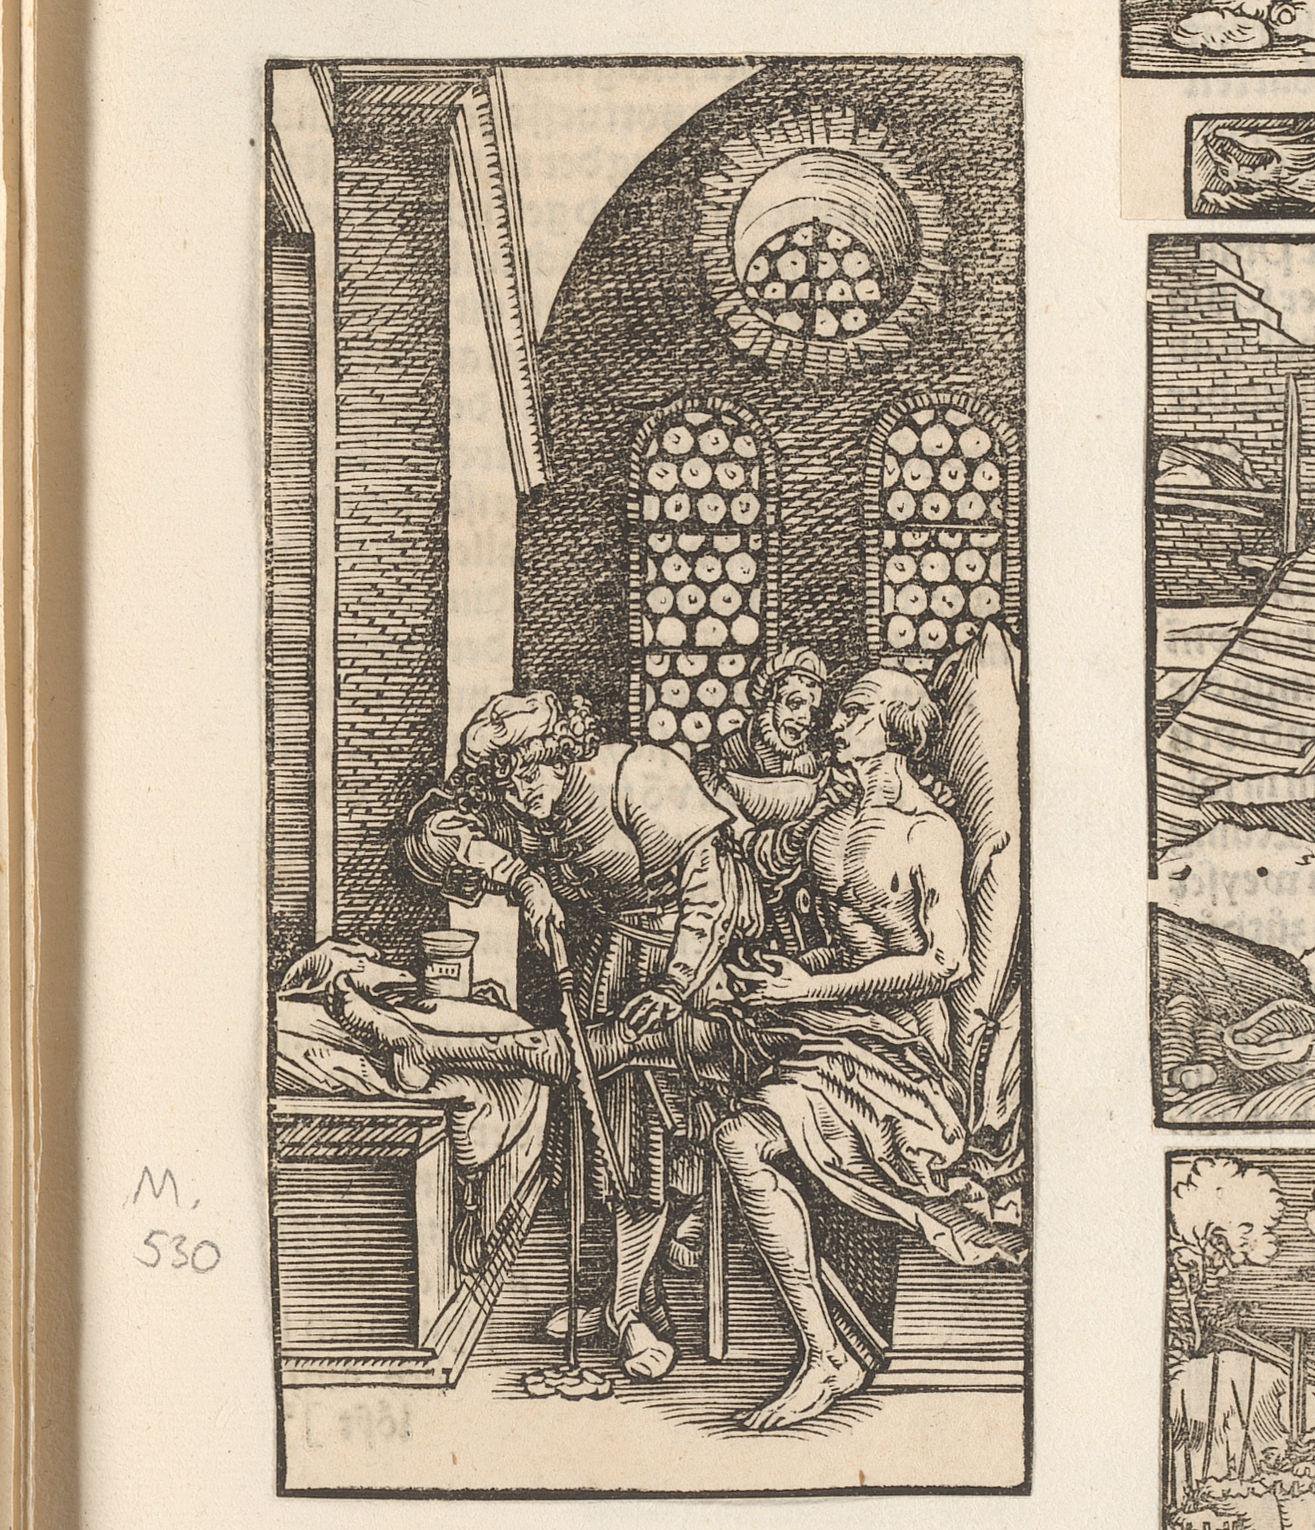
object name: book illustration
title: Beenamputatie middels een zaag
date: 1514-1531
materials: paper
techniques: letterpress printing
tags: amputation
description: Deze prent is gebruikt in: Petrarca, Francesco. Von der Artzney bayder Glück, des guten und widerwertigen: unnd weß sich ain yeder inn Gelück und Unglück halten sol (...). Augsburg: Heinrich Steiner, 1532. Deze uitgave is ook bekend onder de titel 'Trostspiegel in Glück und Unglück'. Deze prent is gebruikt in: Cicero, Marcus Tulius. Officia M.T.C. Ein Buch so Marcus Tullius Cicero der Römer zu seynem (...). [Vertaald uit het Latijn door] Johann von Schwarzenberg. Augsburg: Heinrich Steiner, 1531.